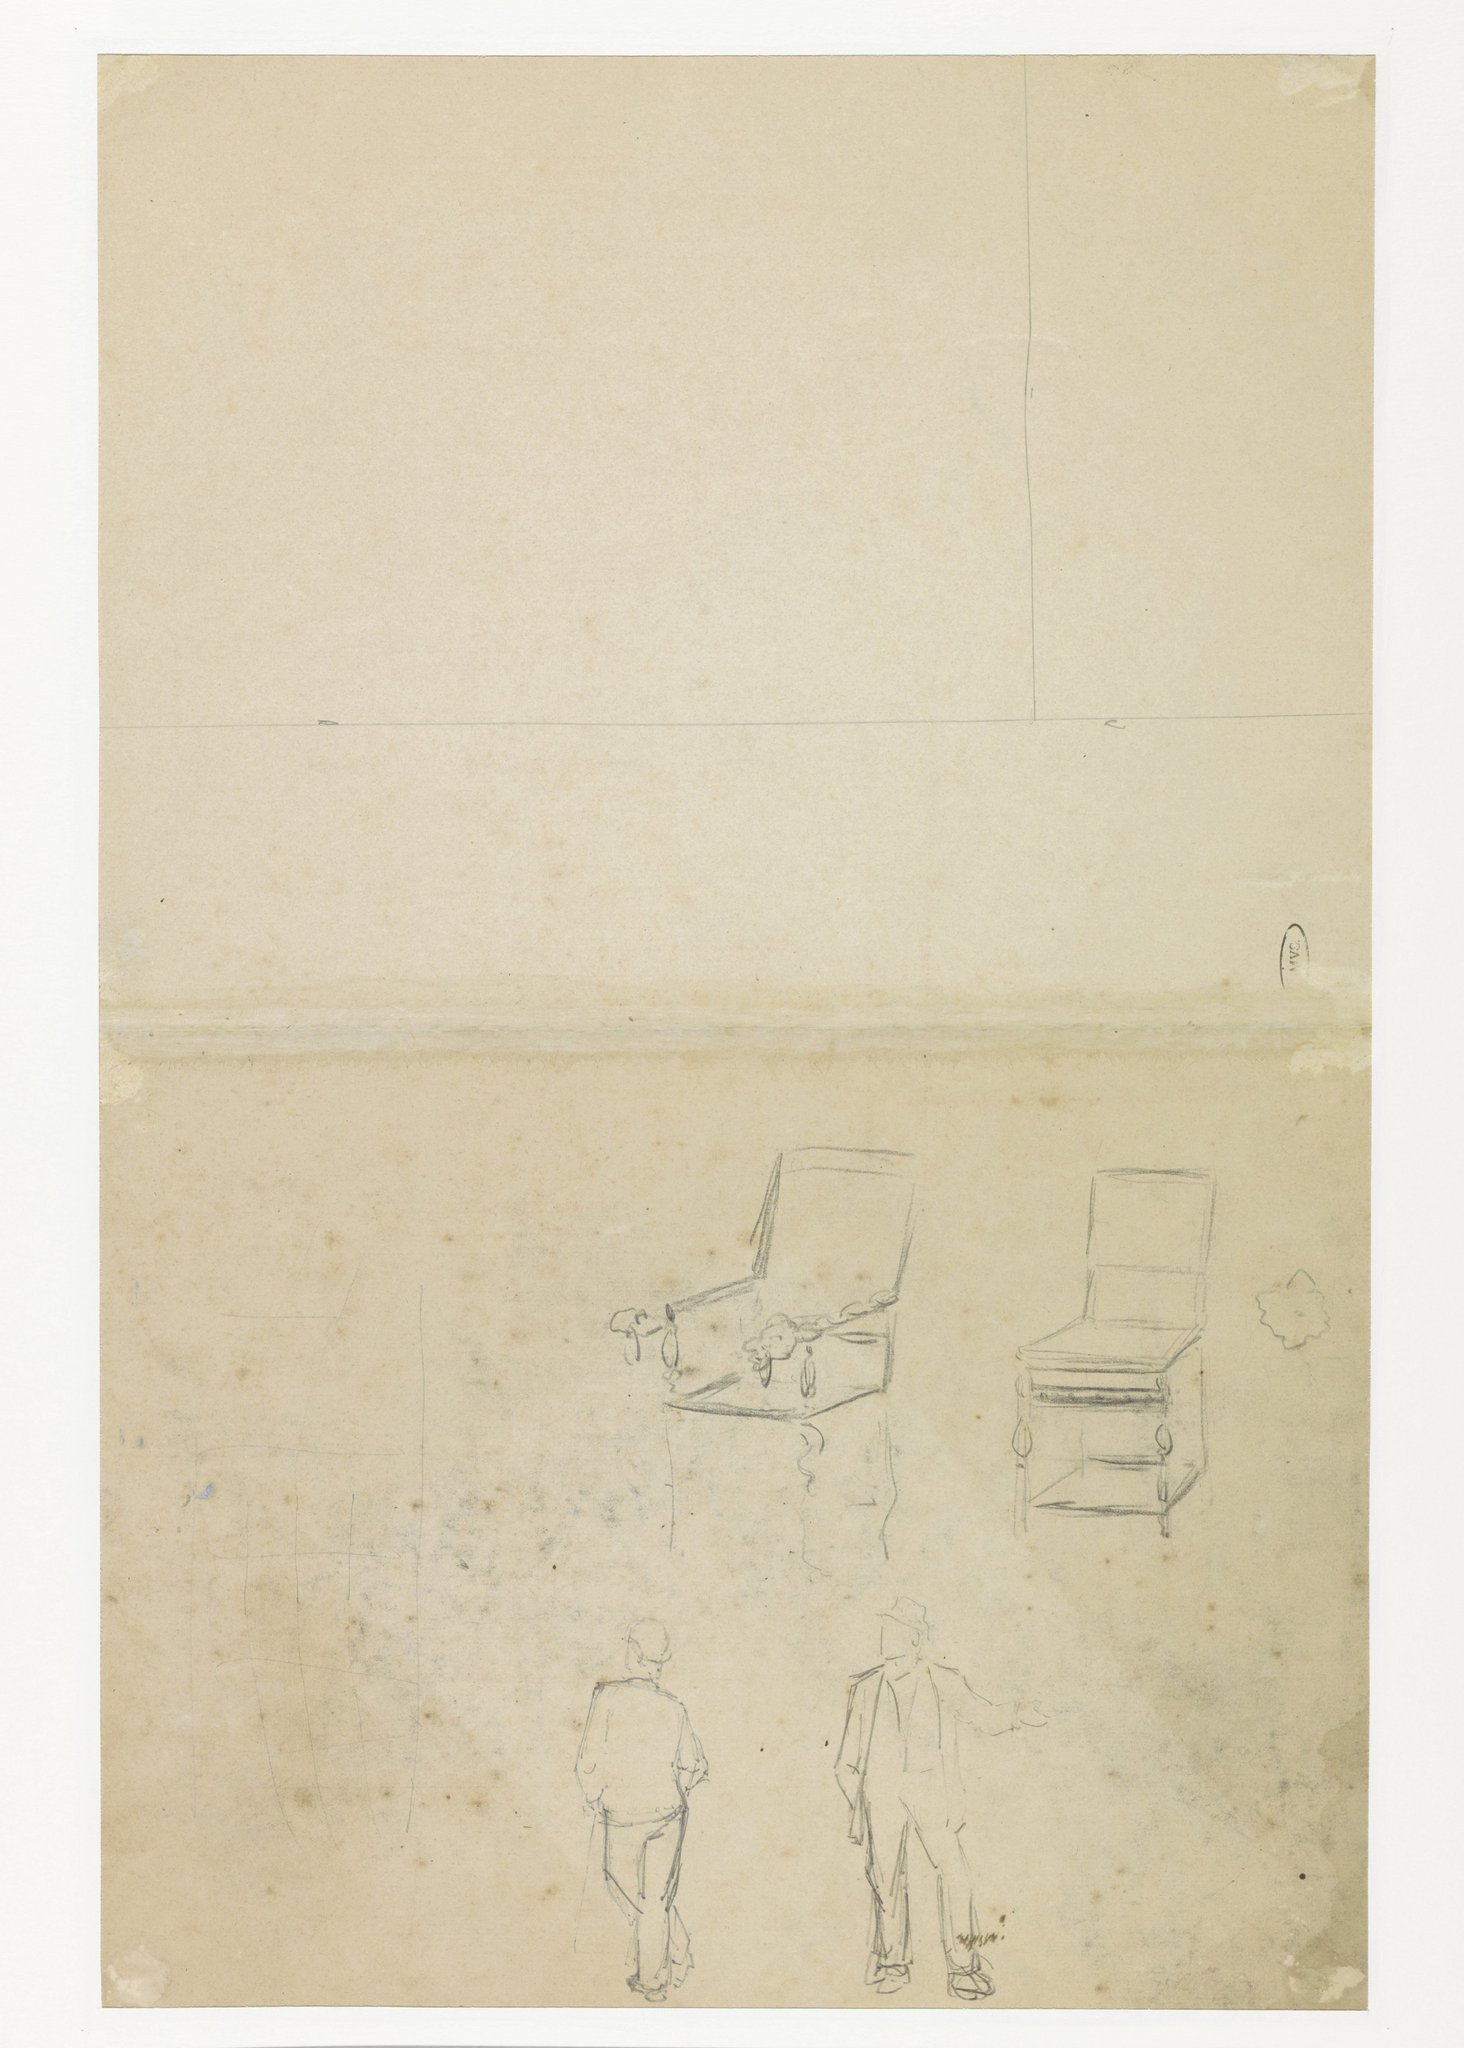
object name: drawing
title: Studies van figuren en stoelen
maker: willem de haas hemken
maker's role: draughtsman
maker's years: 1831-1911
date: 1883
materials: paper, pencil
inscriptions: date